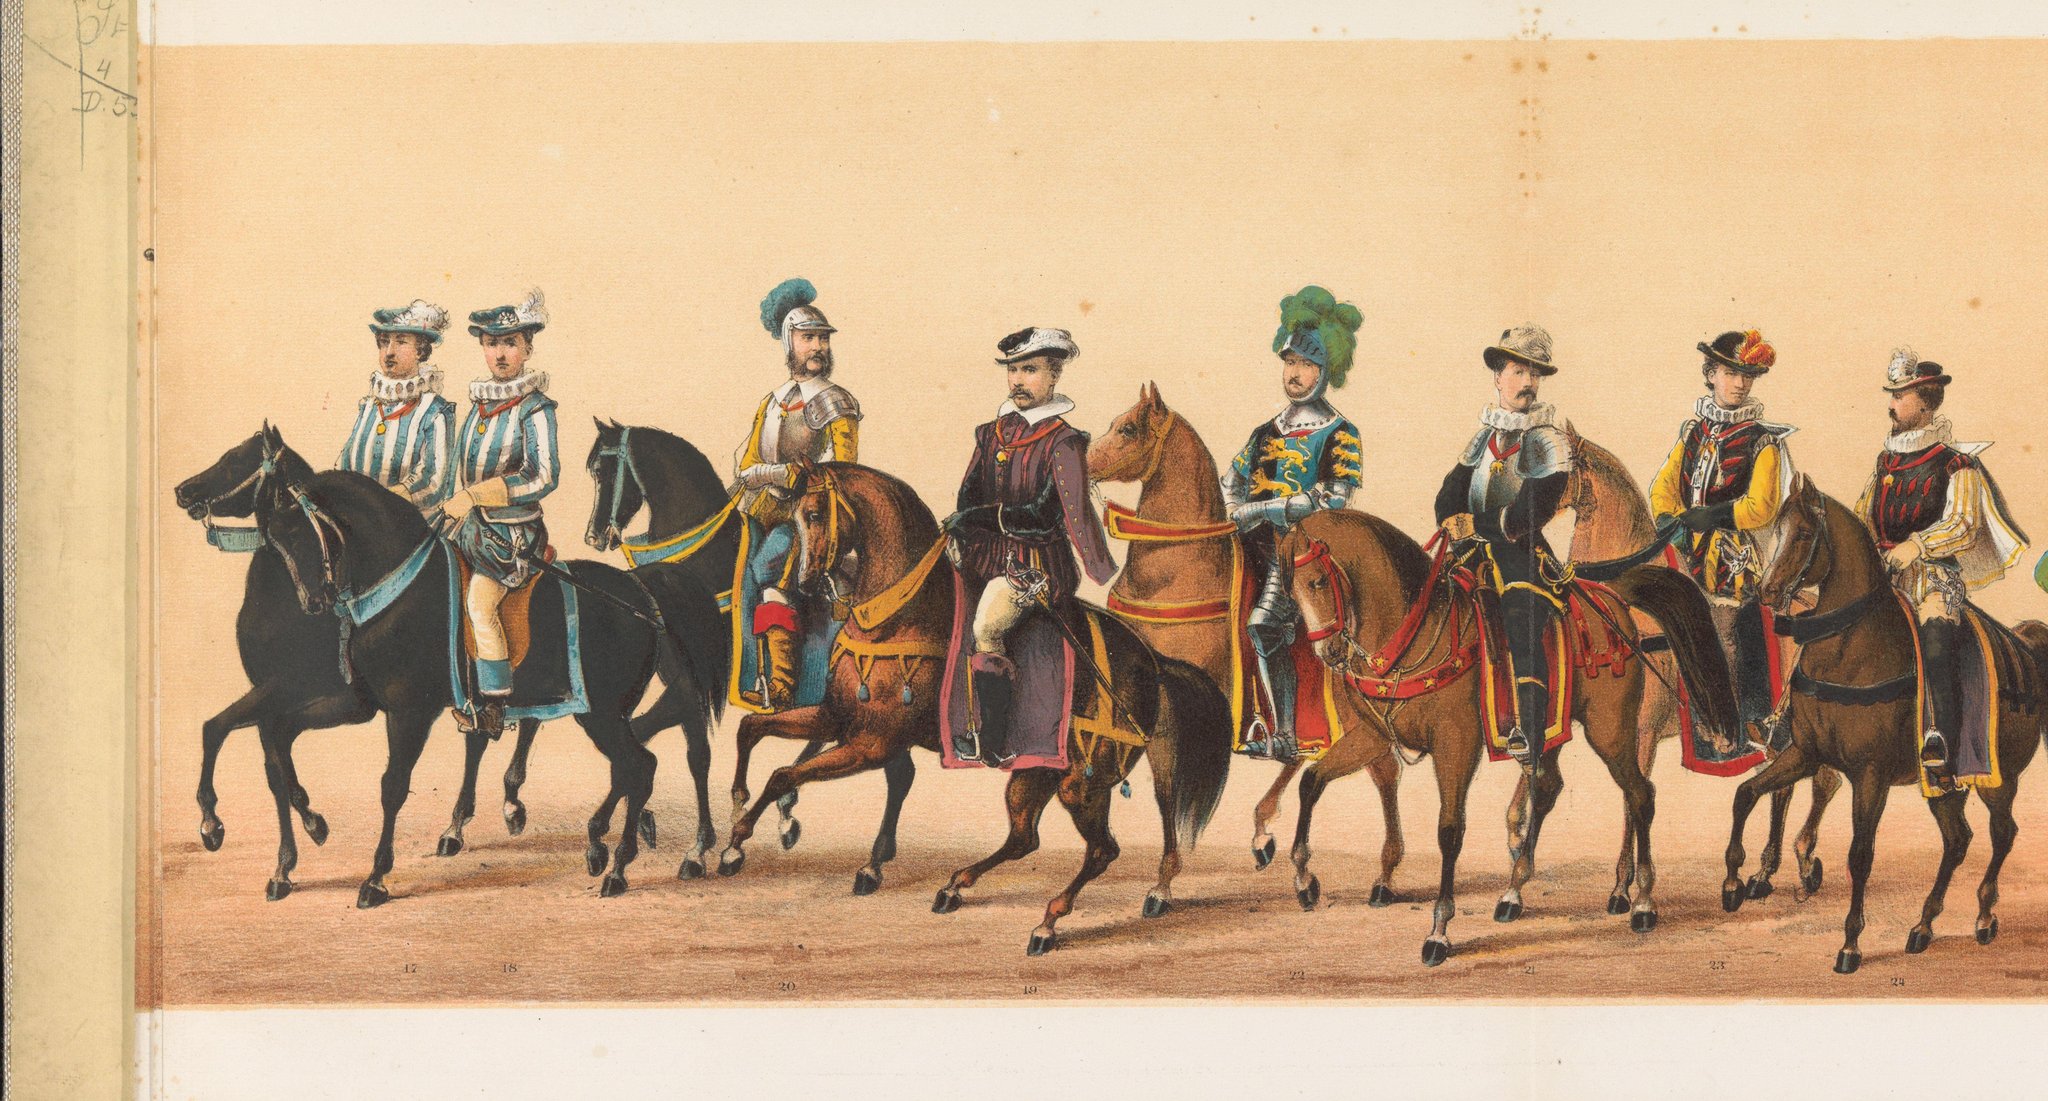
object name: print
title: Optocht gehouden te Haarlem, den 1en April 1872.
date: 1872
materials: paper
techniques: chromolithography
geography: haarlem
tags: festivities on events of national importance (+ parade, pageant, cavalcade ~ festive activities), costumes used in pageants, haarlem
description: Feestelijke optocht gehouden te Haarlem tijdens de Aprilfeesten op 1 april 1872 ter gelegenheid van het 300-jarige onafhankelijkheid van Nederland. Vierde plaat met de groepen genummerd 17-32. Onderdeel van de serie van twaalf aaneen geplakte bladen.